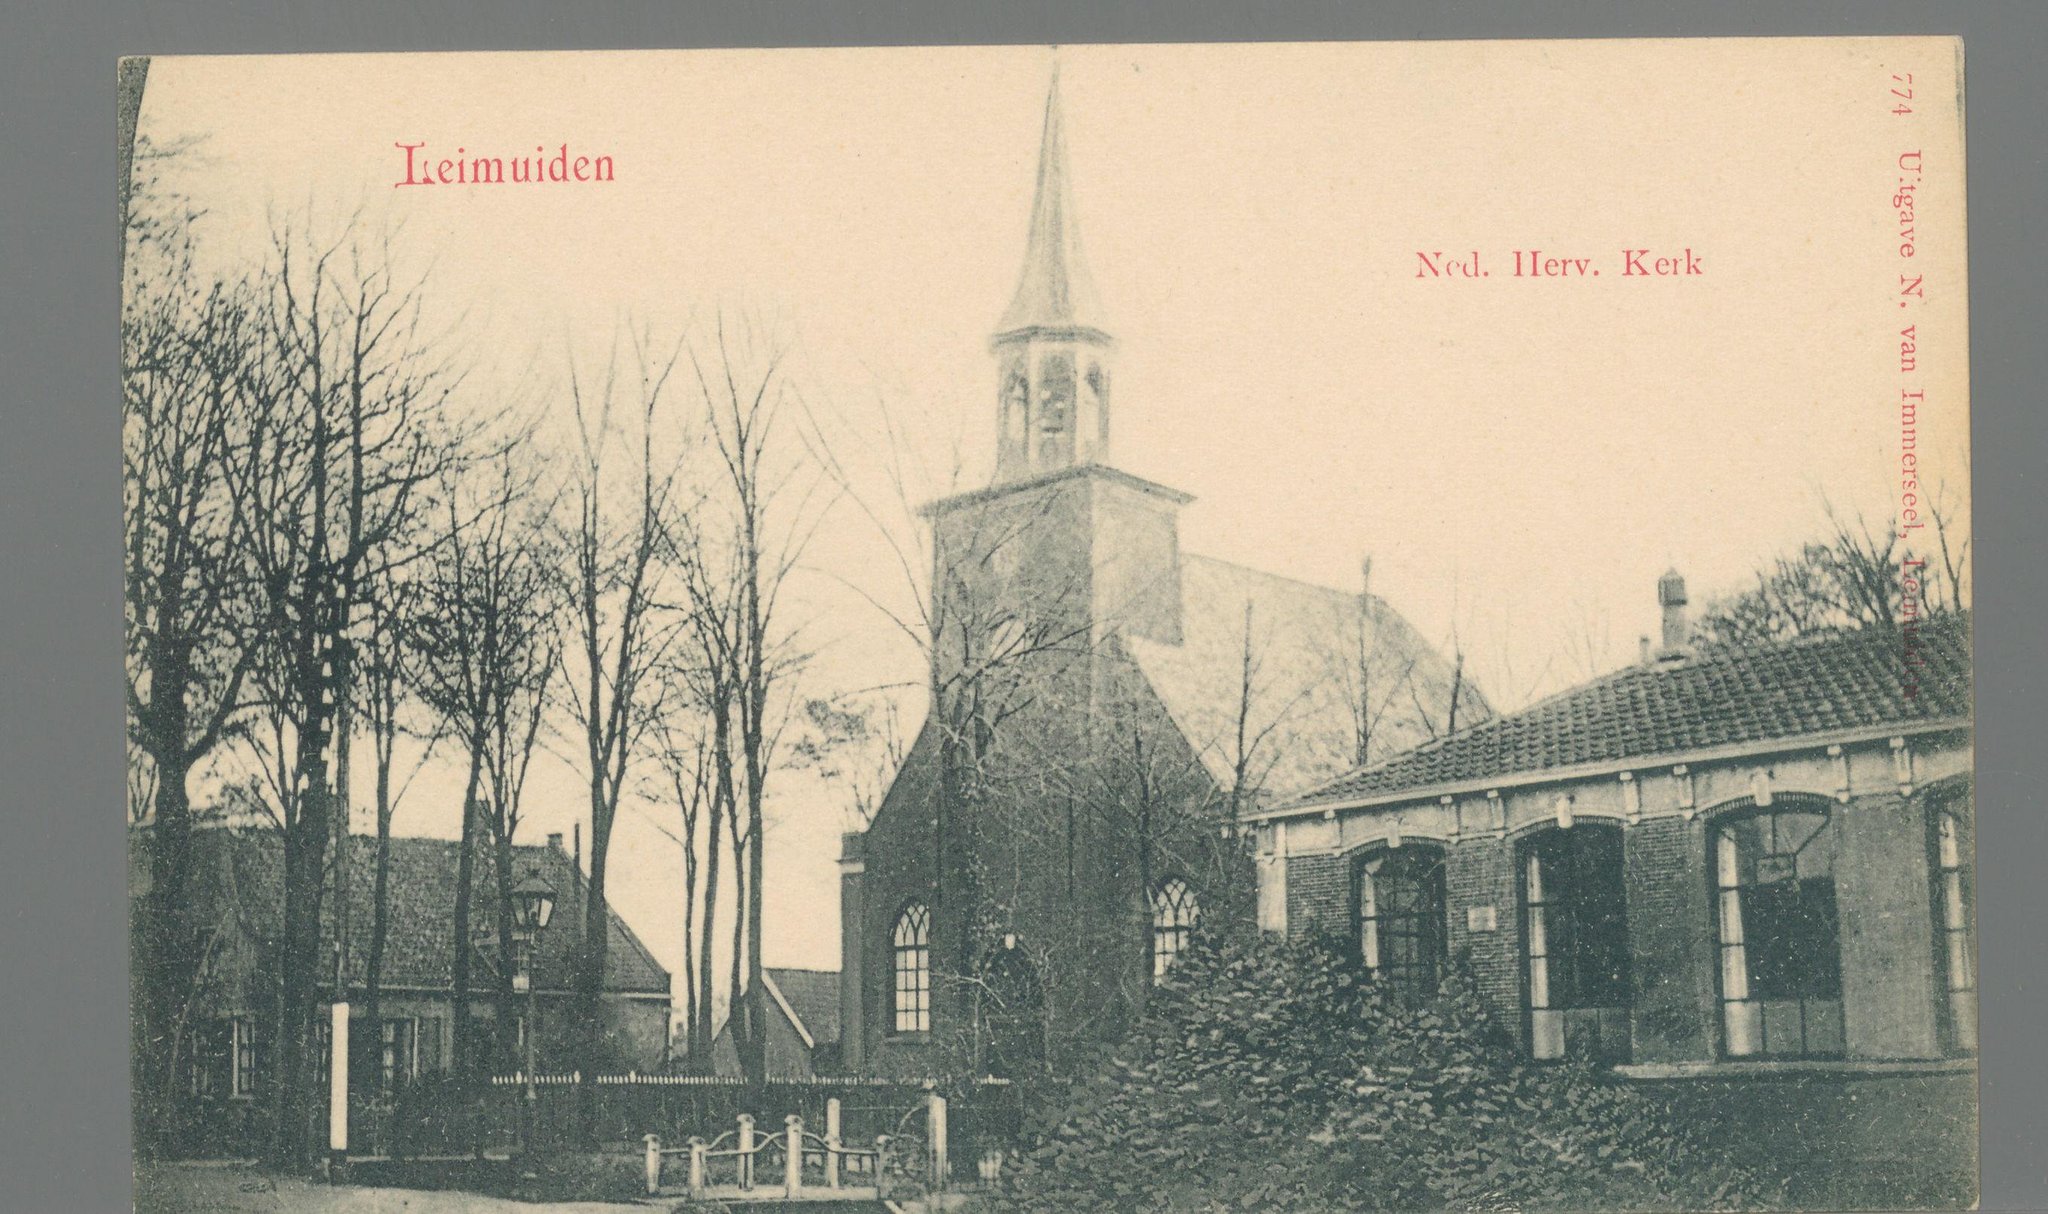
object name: ansichtkaart, prentbriefkaart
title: Leimuiden. Ned. Herv. Kerk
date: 1892-1905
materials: cardboard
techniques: photograph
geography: leimuiden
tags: church (exterior)